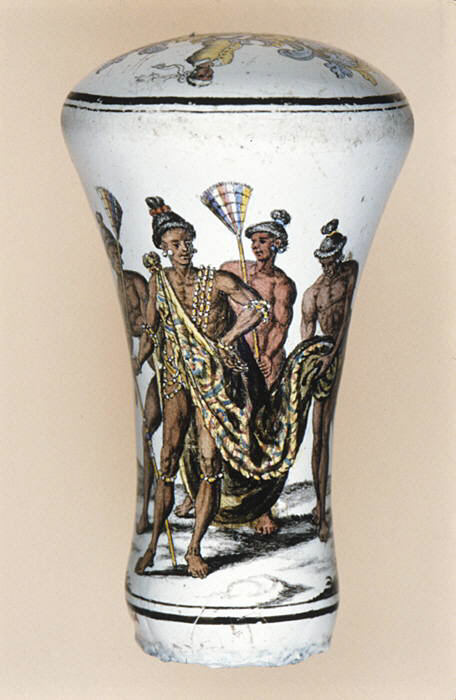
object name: cane handle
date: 1751-1800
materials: copper, enamel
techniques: painting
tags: men,women,coat of arms